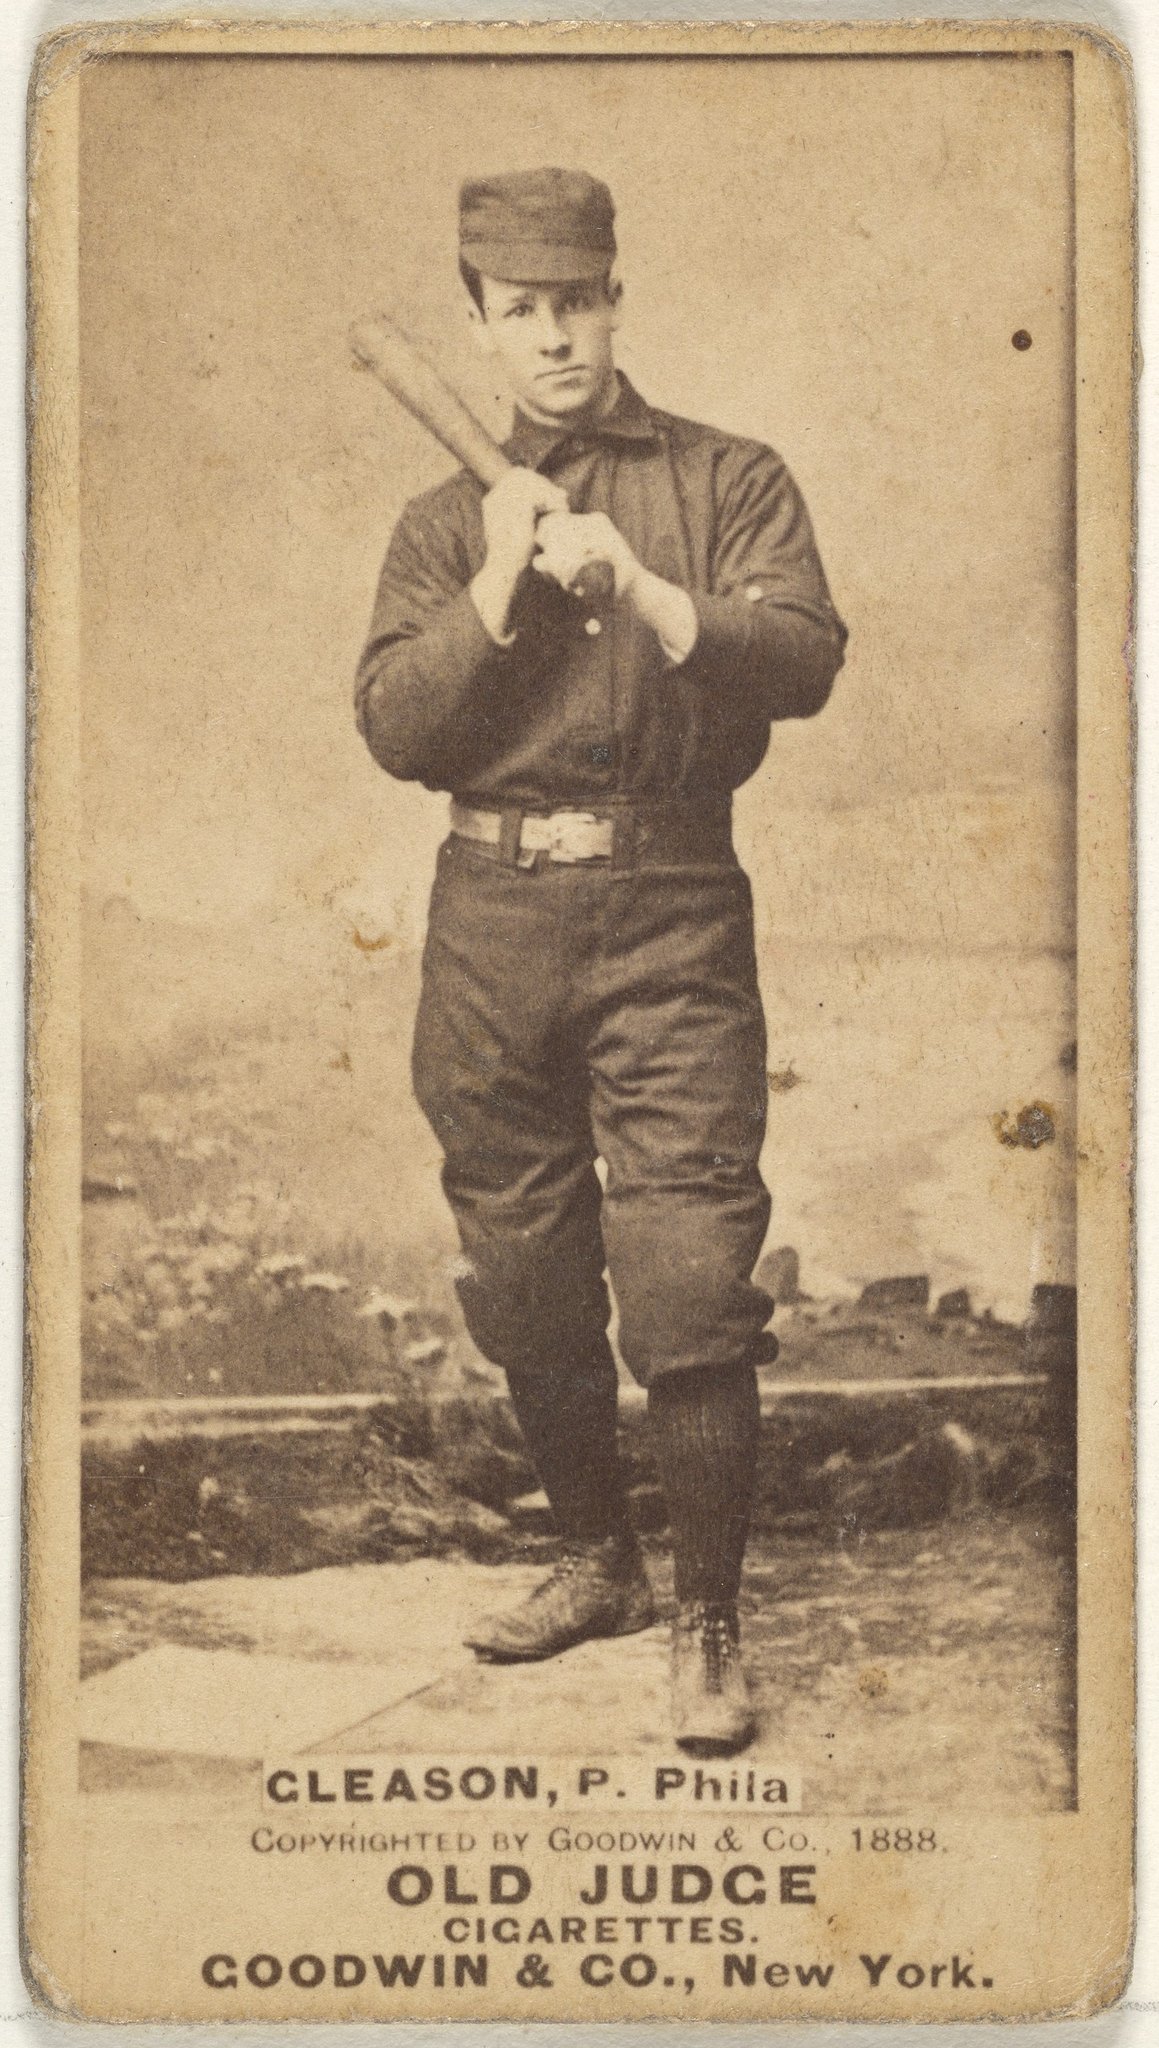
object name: baseball card, photograph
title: William J. "Kid" Gleason, Pitcher, Philadelphia, from the Old Judge series (N172) for Old Judge Cigarettes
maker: goodwin & company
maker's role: publisher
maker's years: 1850-1950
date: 1888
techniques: albumen silver print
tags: men,portraits,baseball,athletes